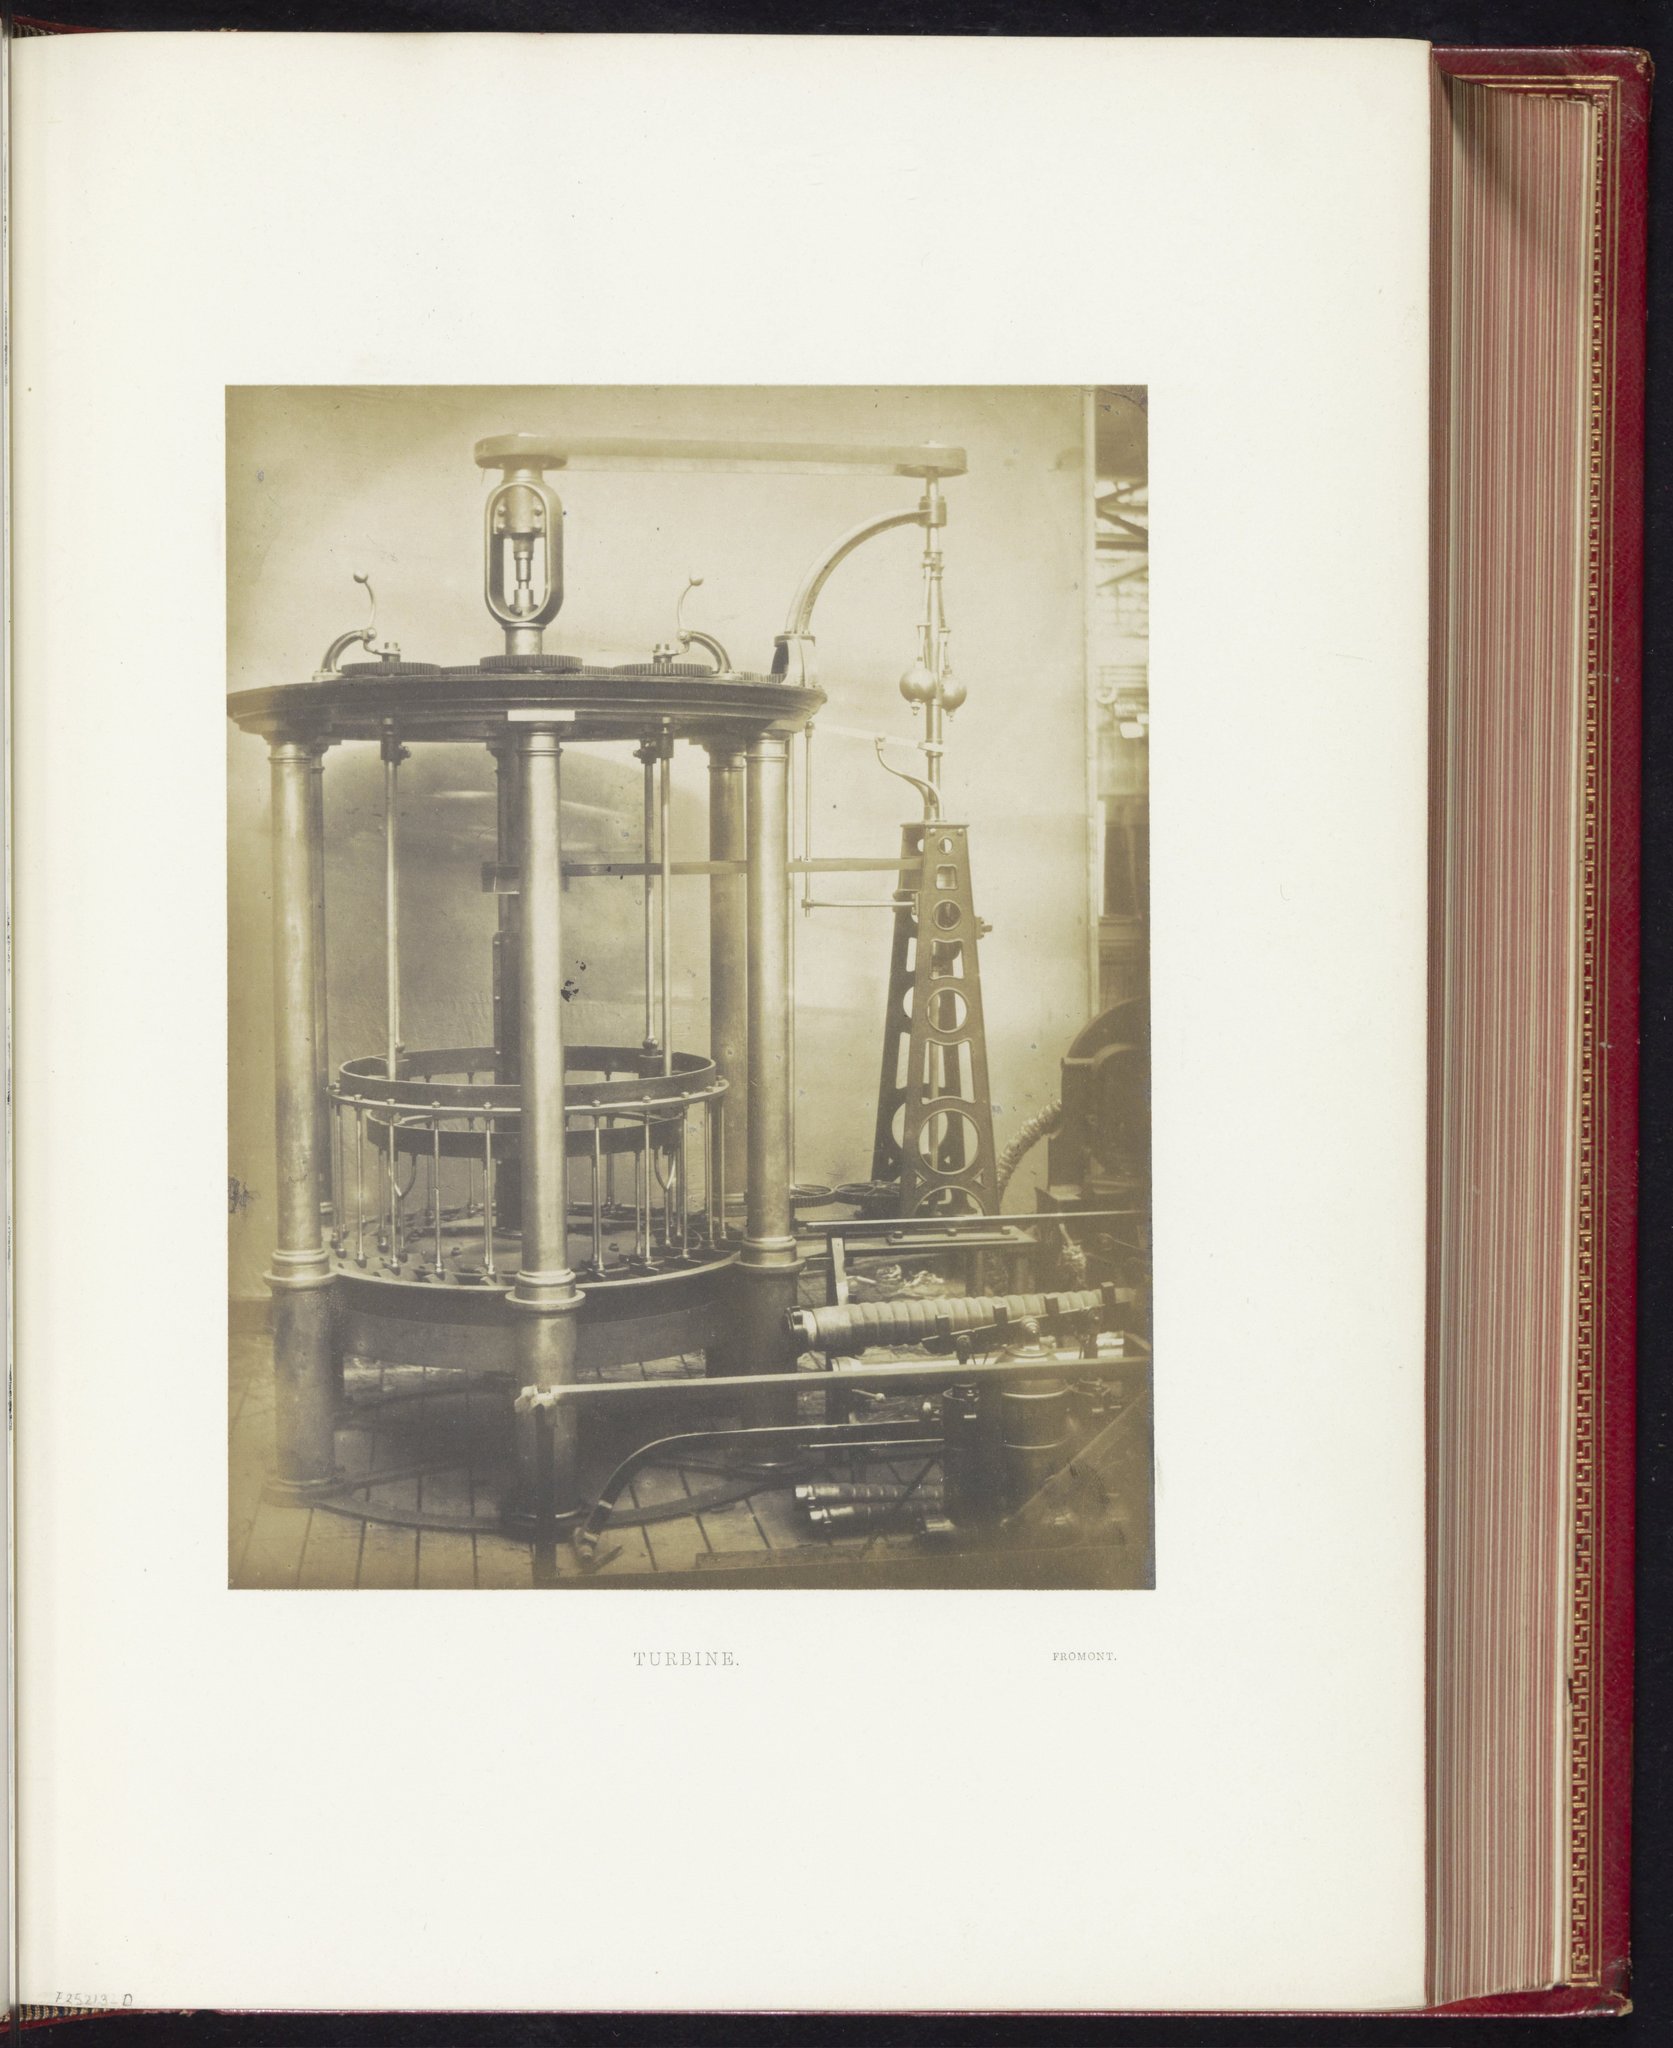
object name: photograph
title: Turbine. Fromont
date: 1851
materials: photographic support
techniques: salted paper print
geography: london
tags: machines, engines ~ crafts and industries, london